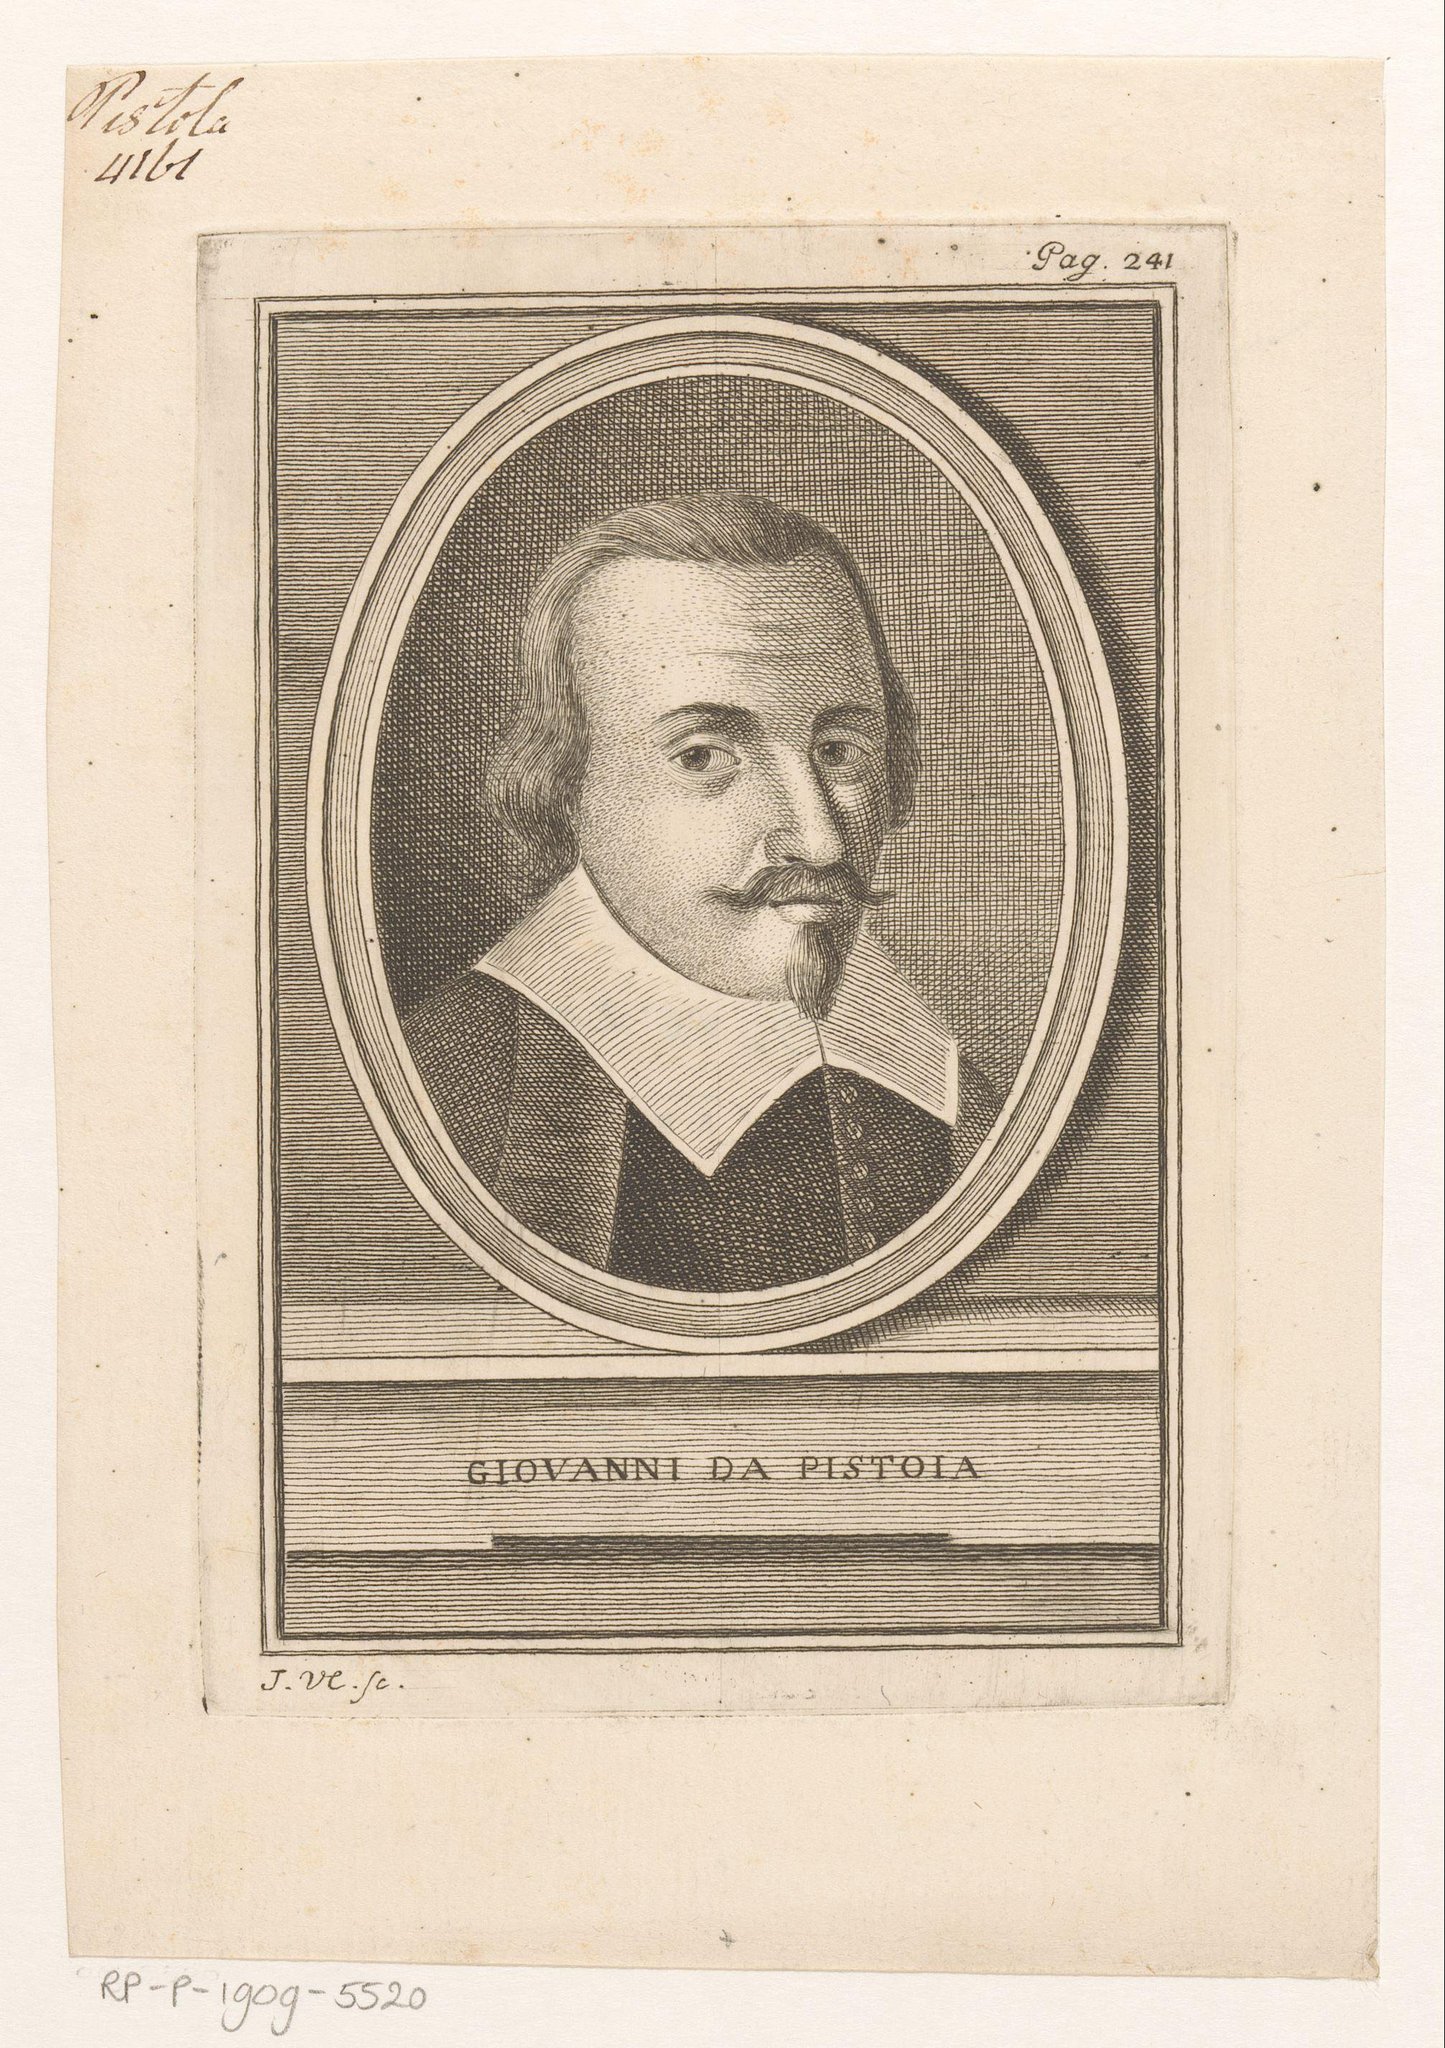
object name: book illustration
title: Portretten van schrijvers die liederen schreven voor Lorenzo de'Medici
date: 1750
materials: paper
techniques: engraving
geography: lucca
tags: historical persons, portrait of a writer, writer, poet, author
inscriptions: collector's mark: Lugt 2228, inscription: ‘Pistola / 4161’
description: Prent gebruikt voor Grazzini, Anton Francesco. Tutti i trionfi, carri, mascherate o canti carnascialeschi andati per Firenze dal tempo del Magnifico Lorenzo de' Medici fino all' anno 1559 : in questa seconda edizione corretti, con diversi MSS. collazionati, delle loro varie lezioni arricchiti, notabilmente accresciuti, e co' ritratti di ciascun poeta adornate. Lucca: Cosmopoli, 1750.